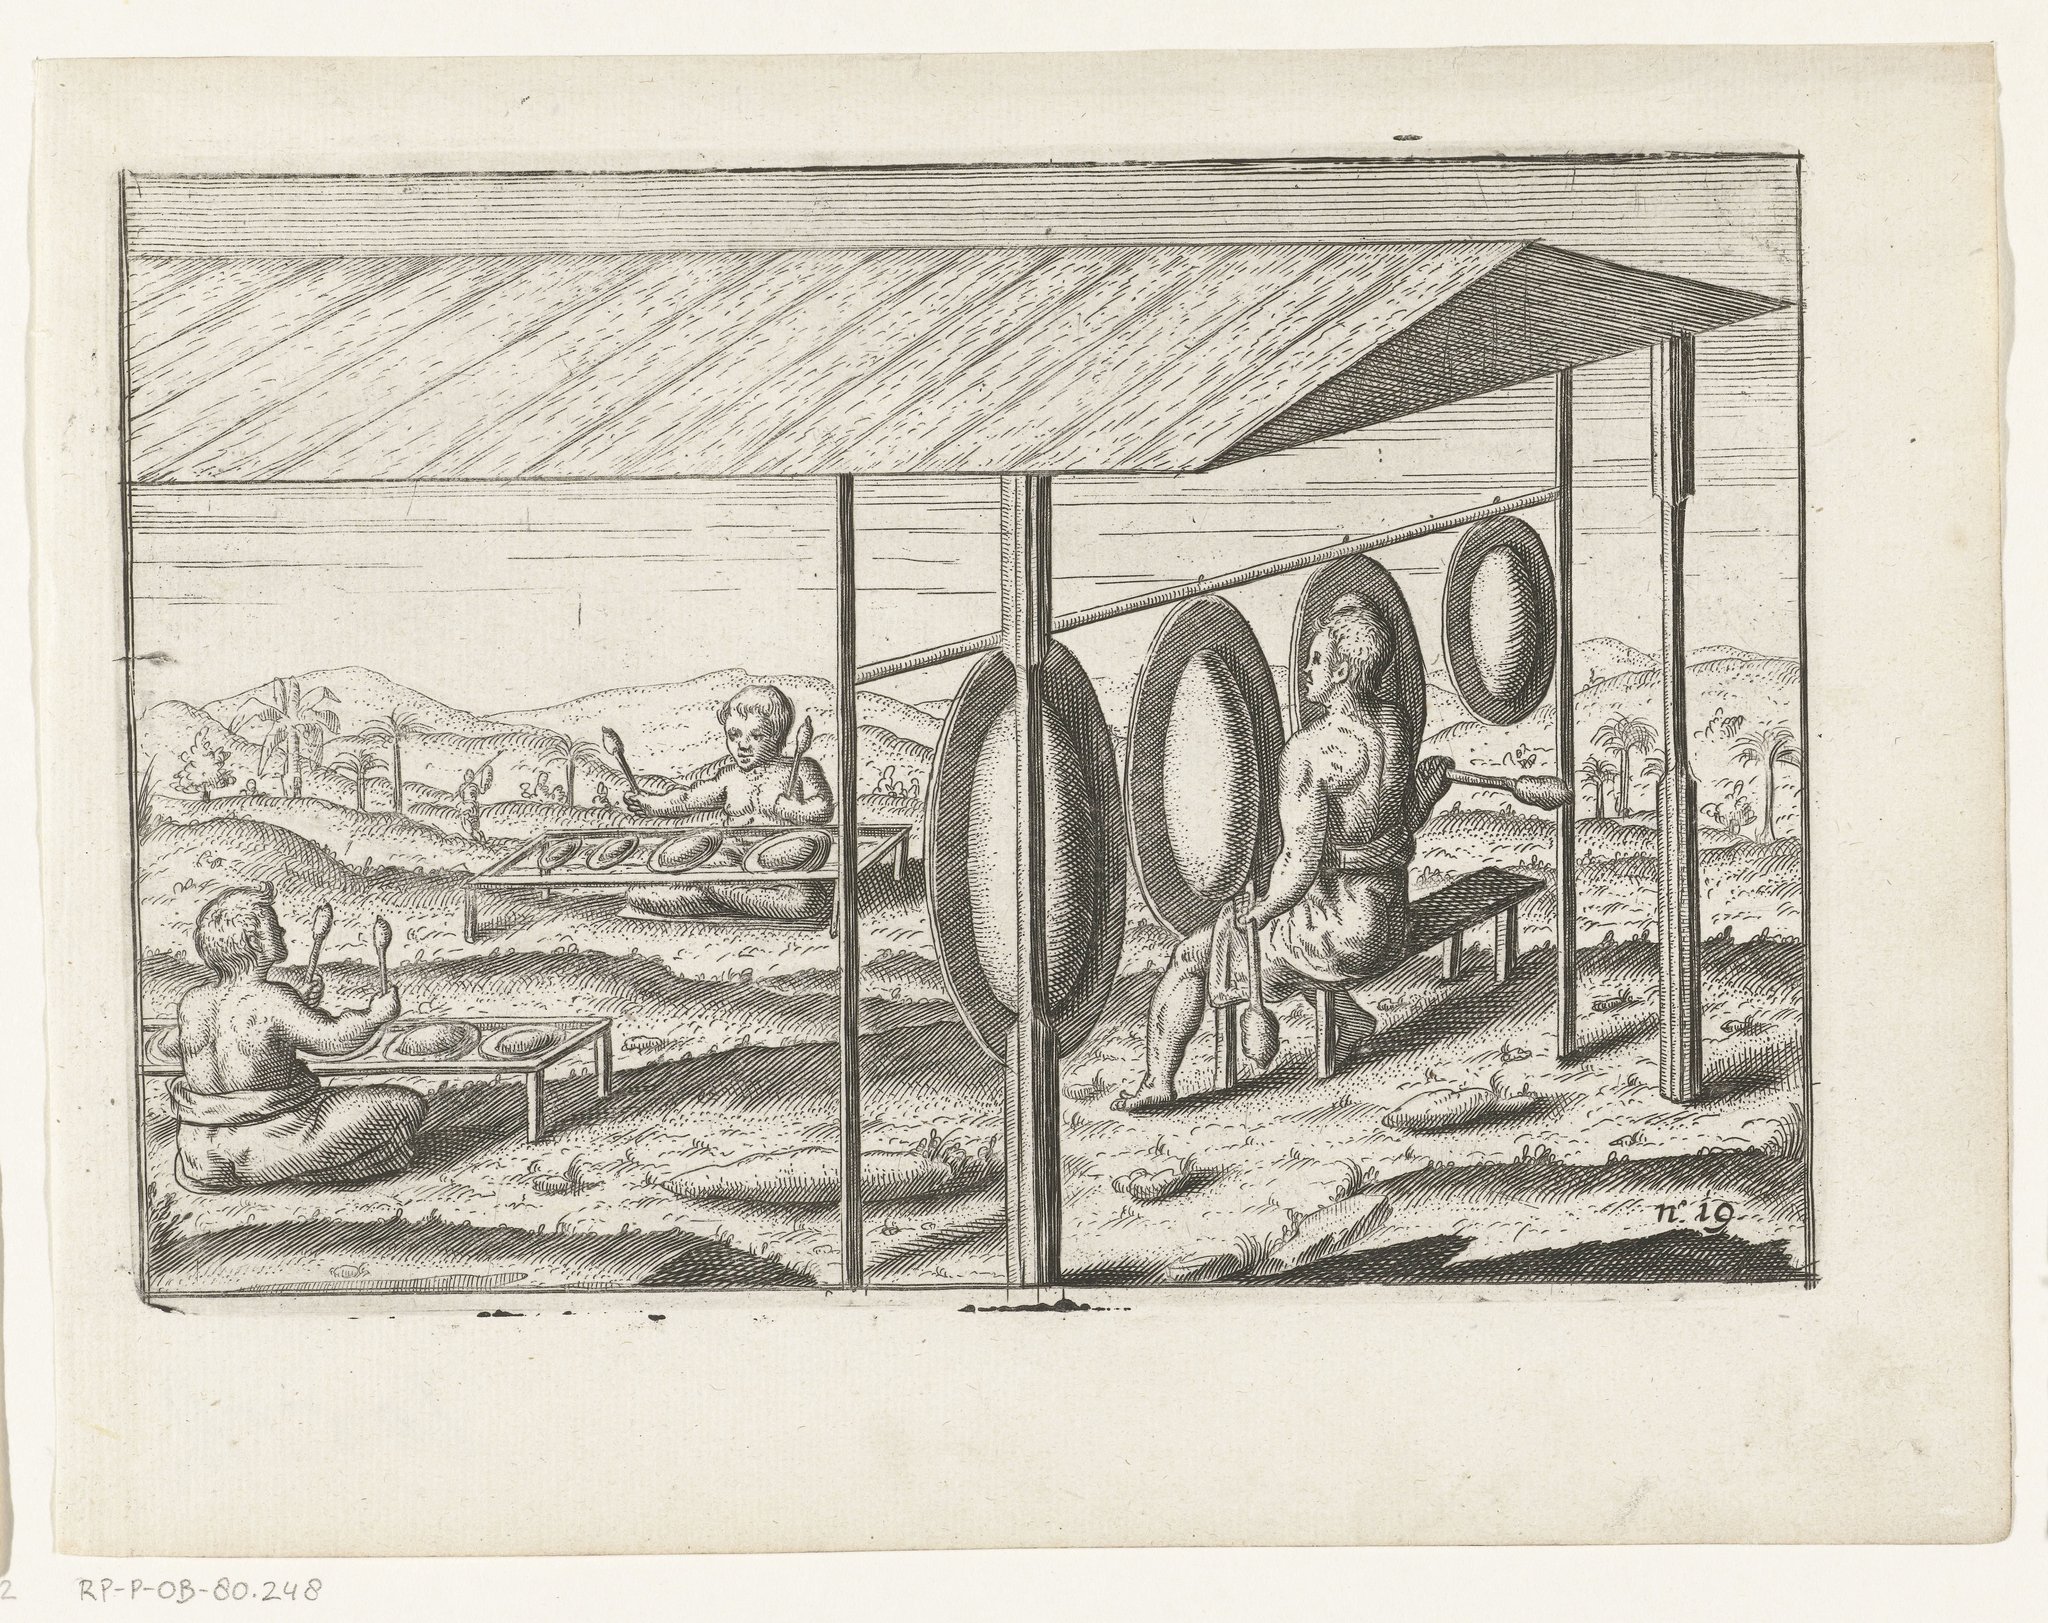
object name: print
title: Javaanse gamelanorkest, 1596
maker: Anonymous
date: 1597-1598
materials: paper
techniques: engraving, etching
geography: northern netherlands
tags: gouda, small group of musicians, chamber orchestra, jazz band, landscapes in tropical and sub-tropical regions, exploration, expedition, voyage of discovery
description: Gebruikt als illustratie eerst in: Willem Lodewijcksz, D'eerste boeck. Historie van Indien, waer inne verhaelt is de avontueren die de Hollandtsche schepen bejeghent zijn, Cornelis Claes, Amsterdam 1598. In deze opgewerkte staat gebruikt in: De Eerste Schipvaerd der Hollandsche Natie naer Oost-Indien, waer inne verhaelt wordt al wat haer sonderlings onder wegen bejegent is ... ghetrocken uyt verscheyden Iournalen ofte dagh-registers daer van ghemaeckt, zeer vermaeckelijck ende nut om lesen. Opgenomen in: I. Commelin, Begin ende voortgangh, van de Vereenighde Nederlantsche Geoctroyeerde Oost-Indische Compagnie, J. Janssonius, Amsterdam 1646. Genummerd: 19.